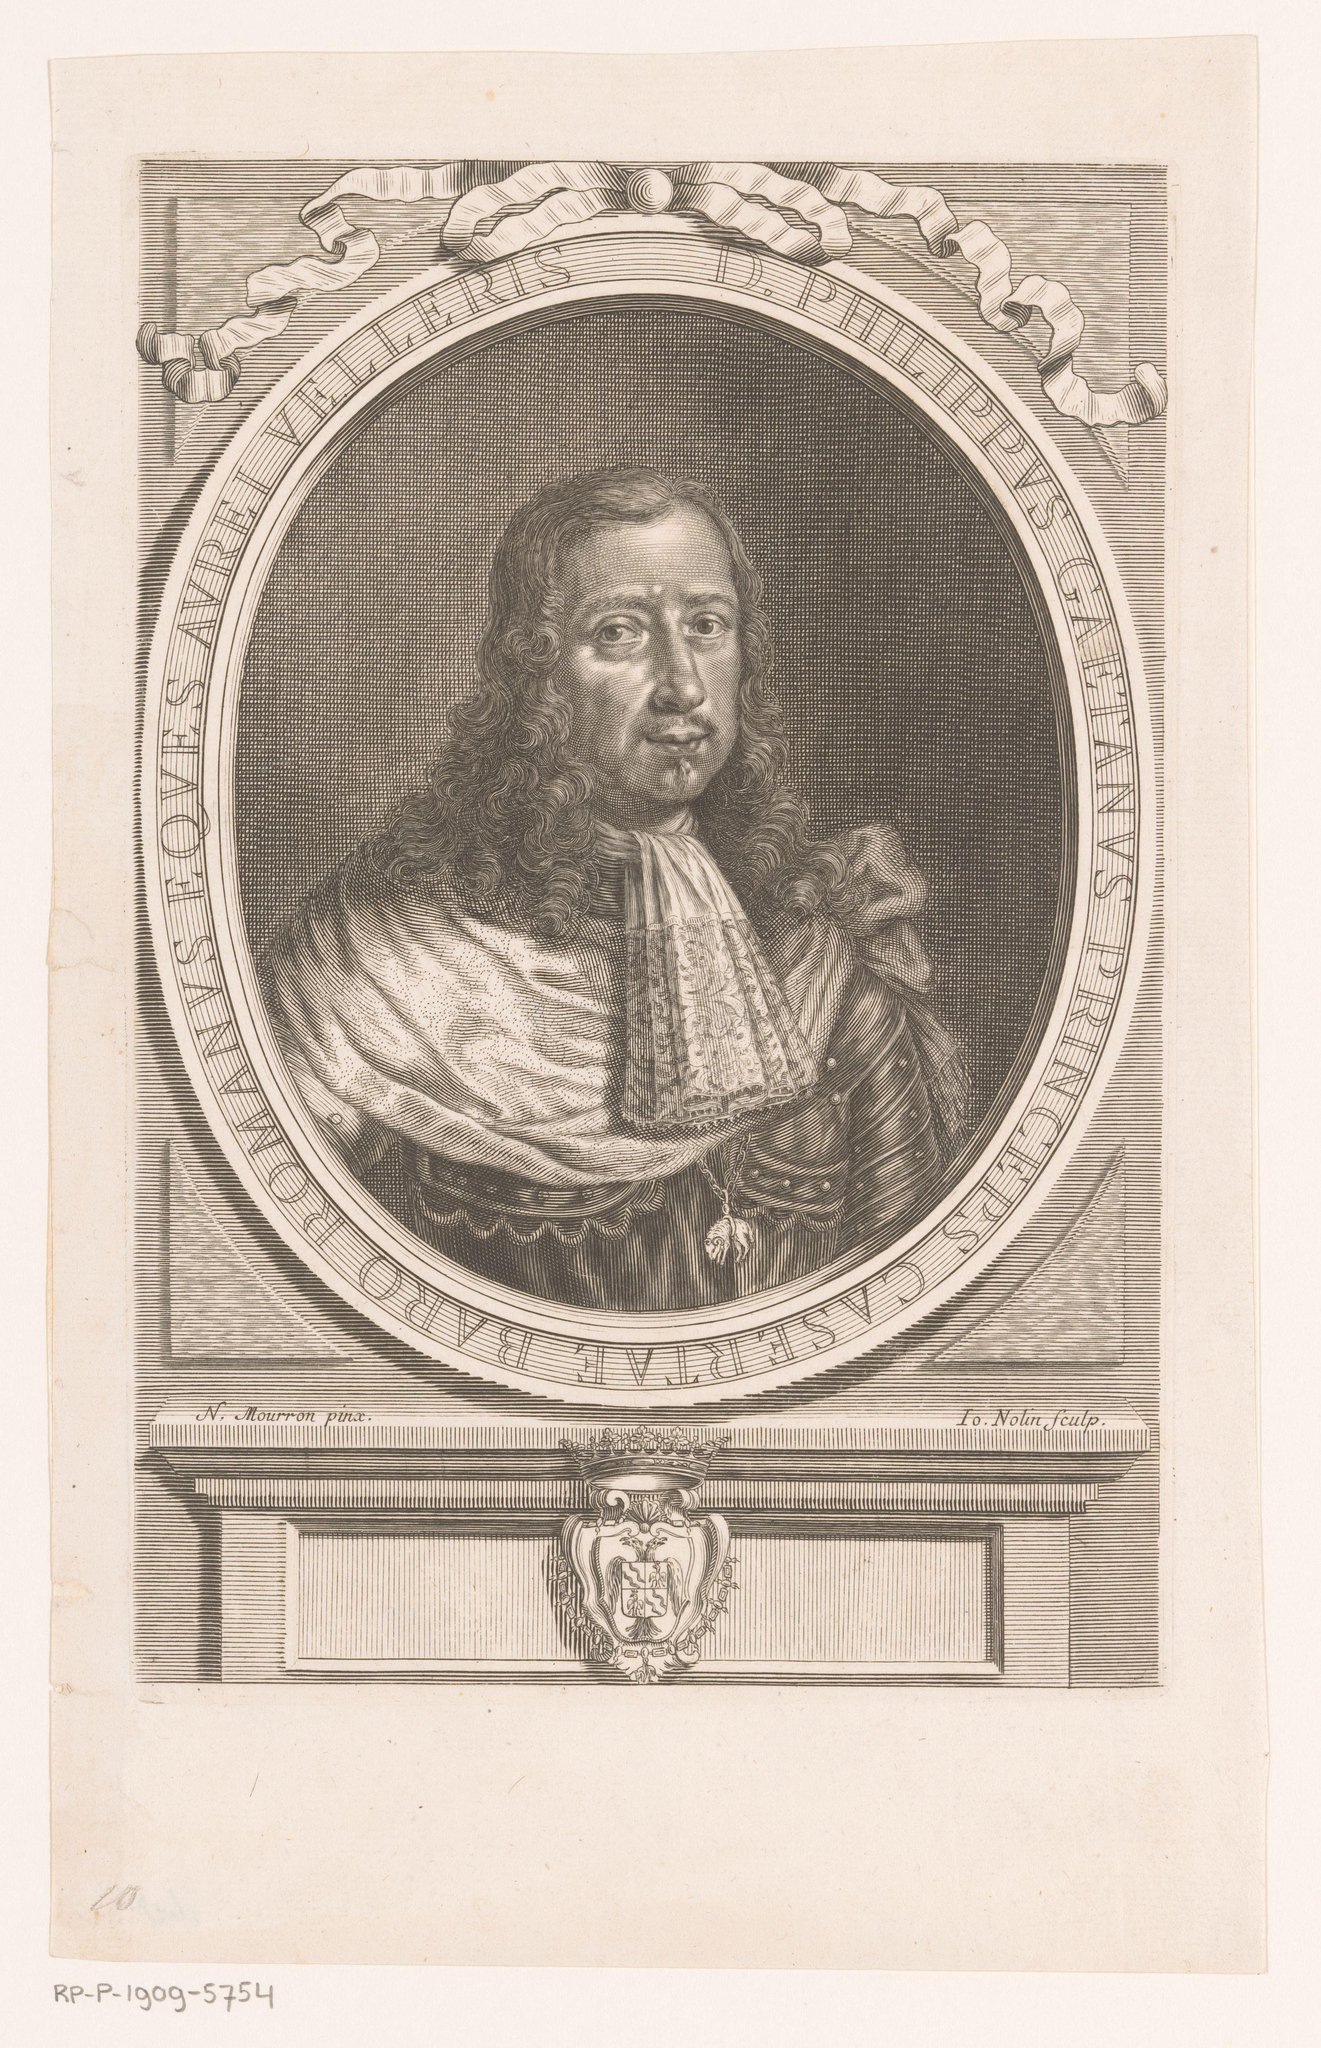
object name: print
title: D. Philippus Gaetanus (...)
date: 1667-1708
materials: paper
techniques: engraving, etching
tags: prince, historical persons, knighthood order of the golden fleece - insignia of a knighthood order, e.g.: badge, chain (with name of order)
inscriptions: collector's mark: Lugt 2228